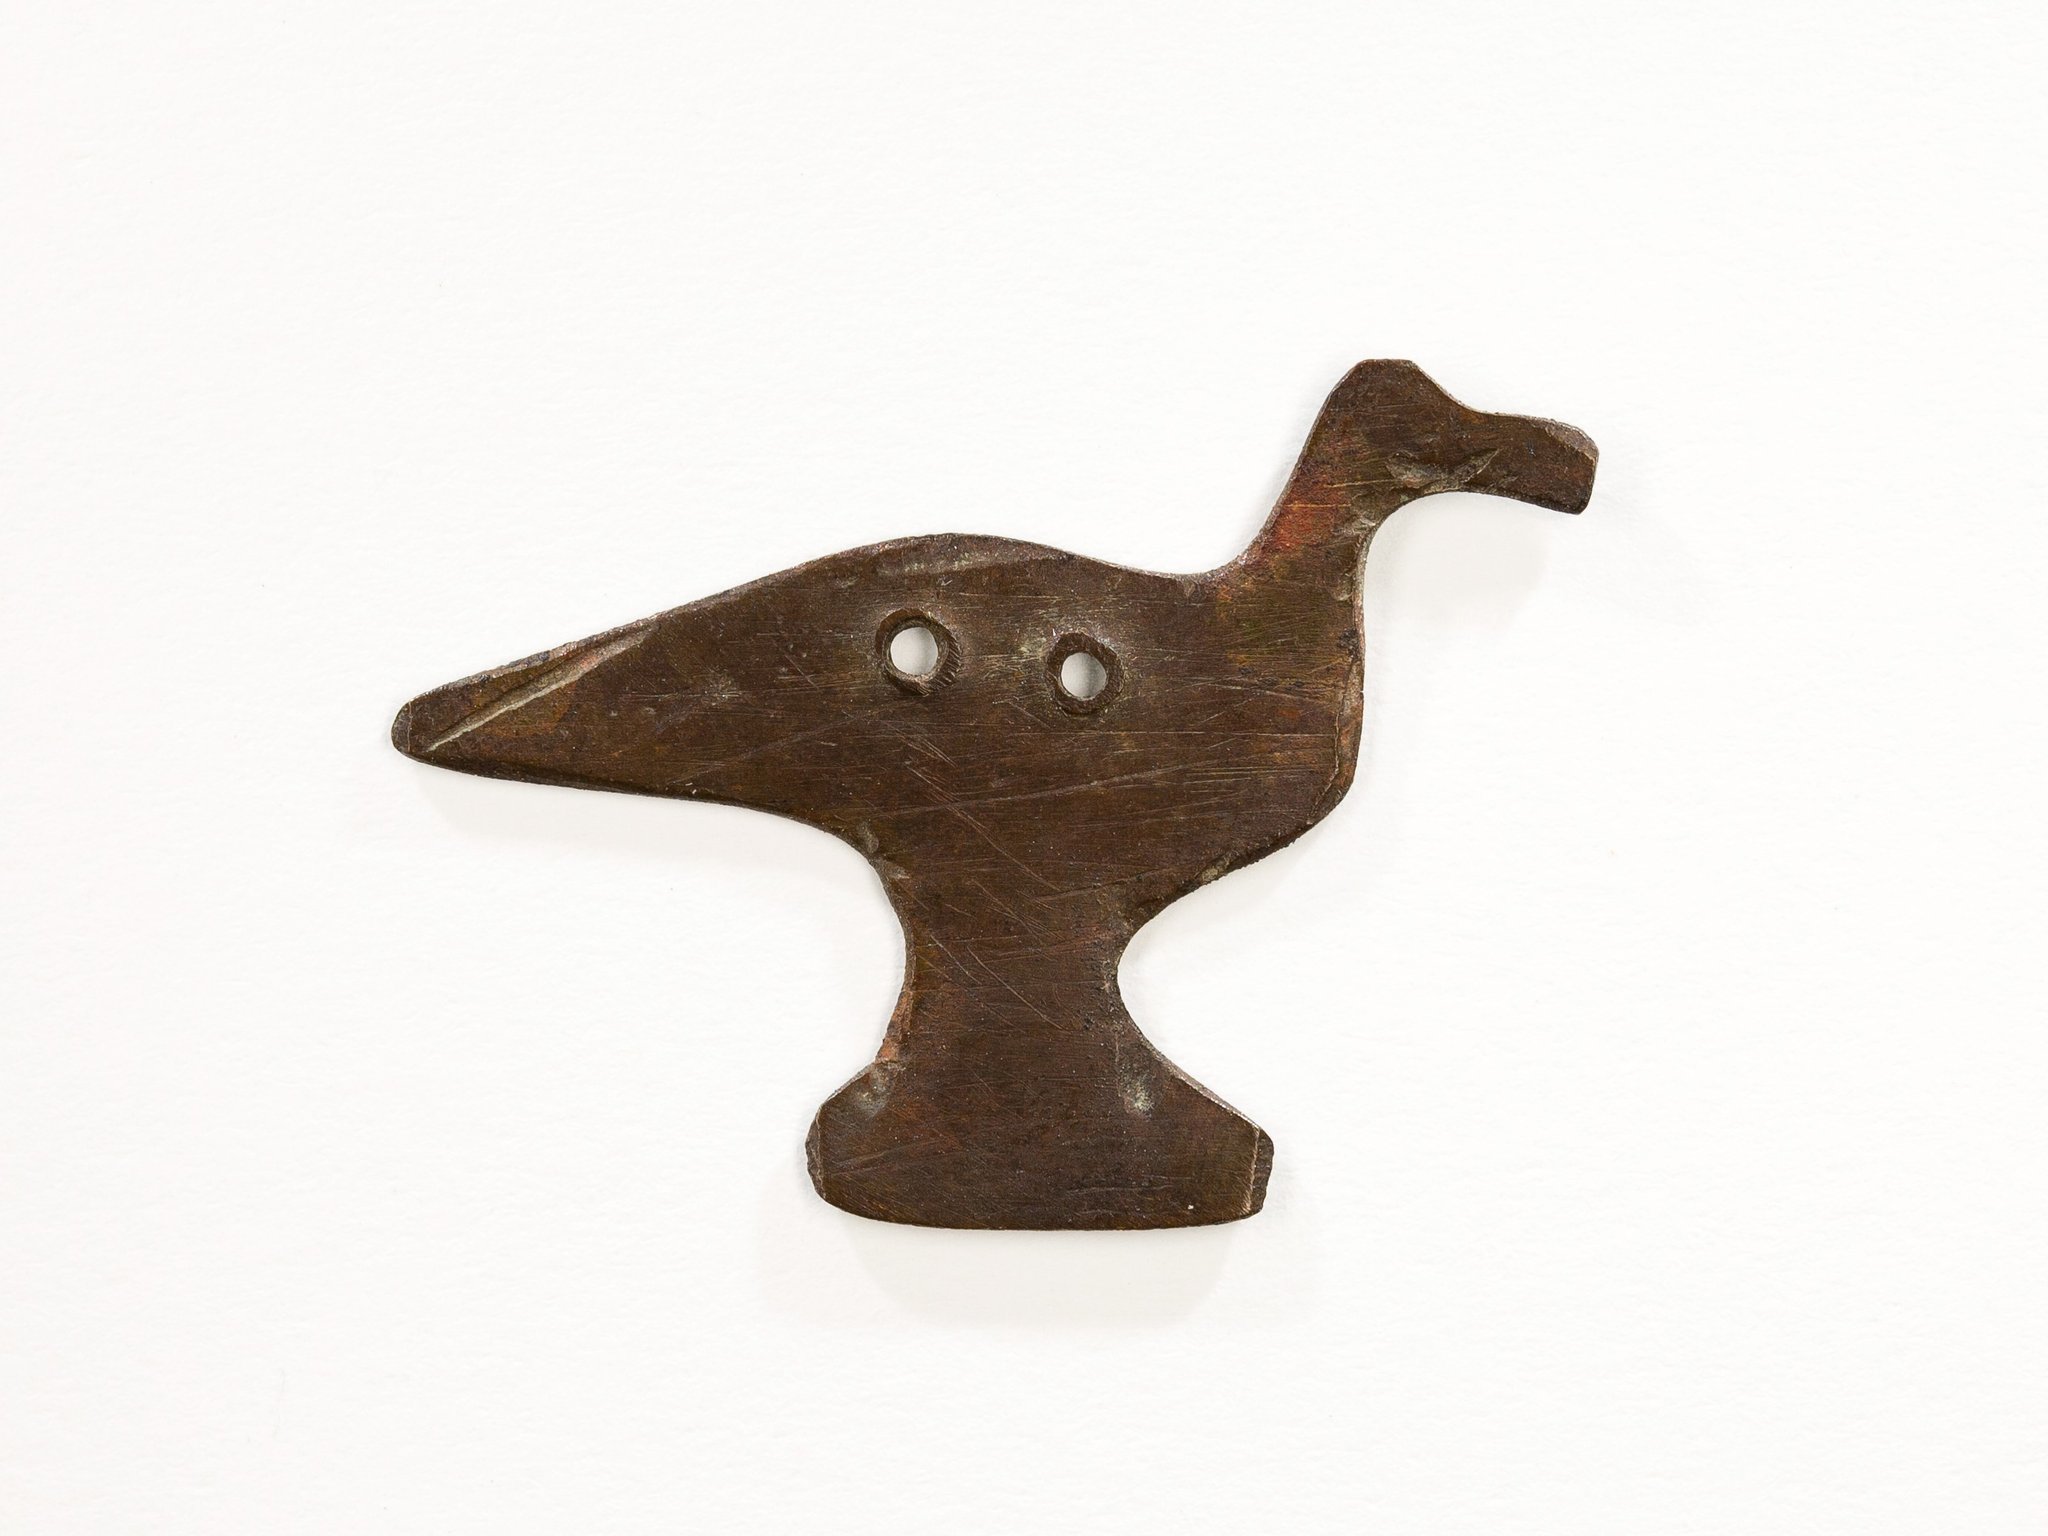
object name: votive, plaque, bird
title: Votive, bird figure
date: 1479-1458 BCE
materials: bronze, copper alloy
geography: egypt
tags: birds